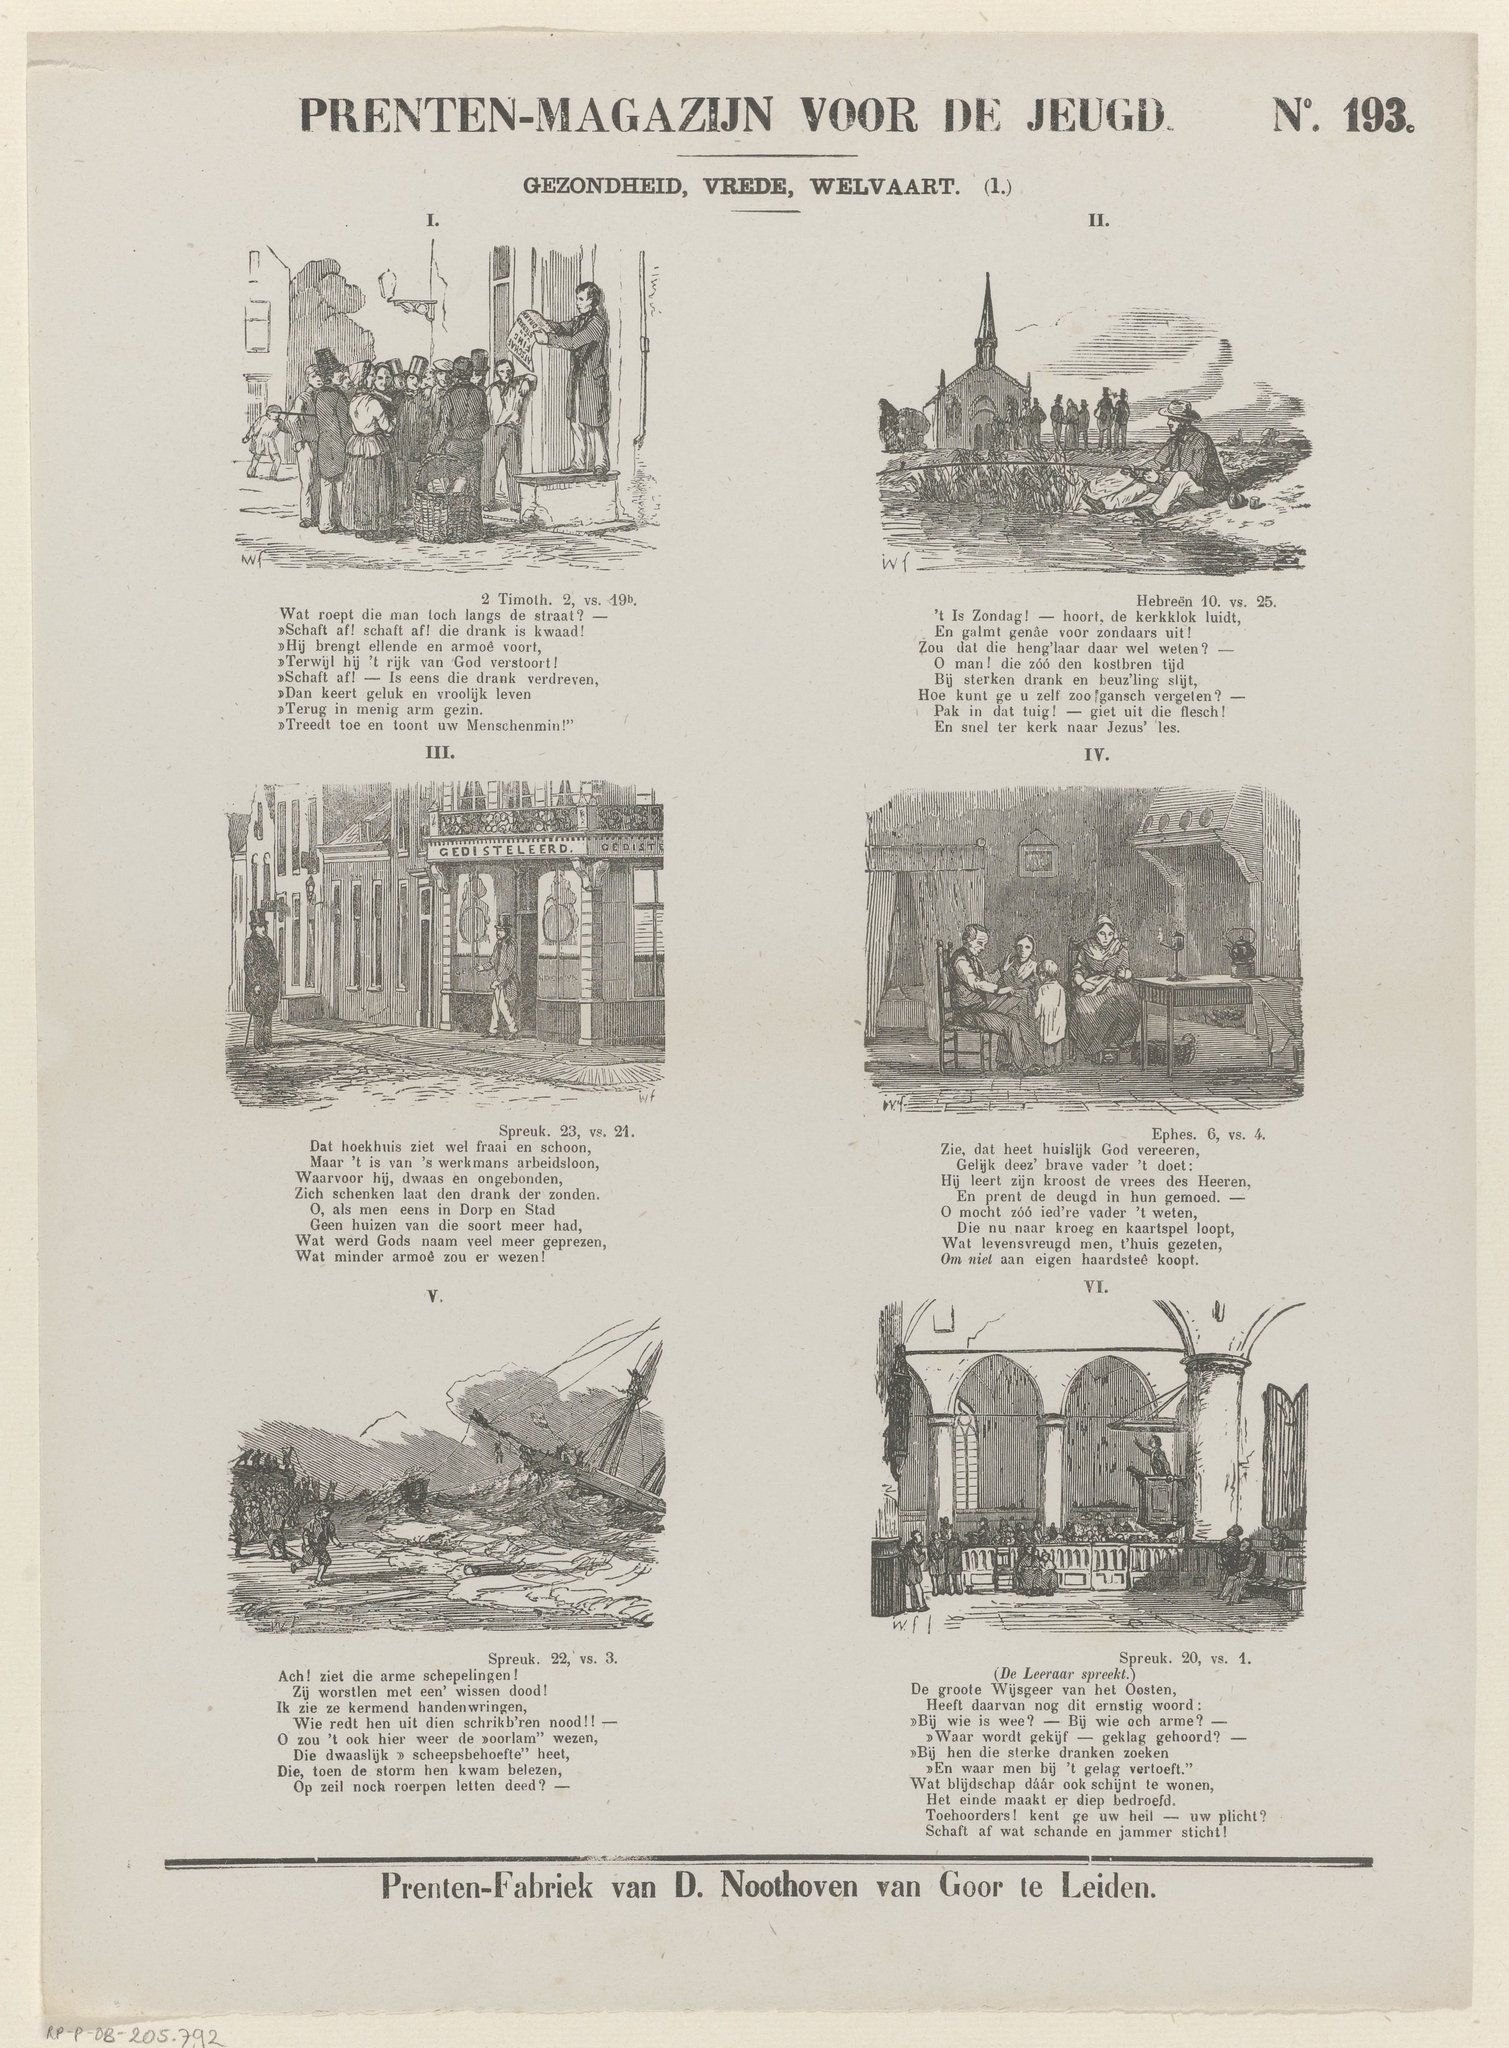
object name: popular print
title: Prenten-magazijn voor de jeugd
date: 1850-1881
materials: paper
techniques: letterpress printing, engraving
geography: leiden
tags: family, relationship, descent, wreck ashore, preaching (in general), fishing (sports)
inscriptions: collector's mark: Lugt 2760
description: Blad met 6 voorstellingen van verschillende aard, waaronder voorstellingen van een visser, een gezin en een scheepswrak. Boven elke afbeelding een titel, onder elke afbeelding een achtregelig vers. Genummerd rechtsboven: No. 193.